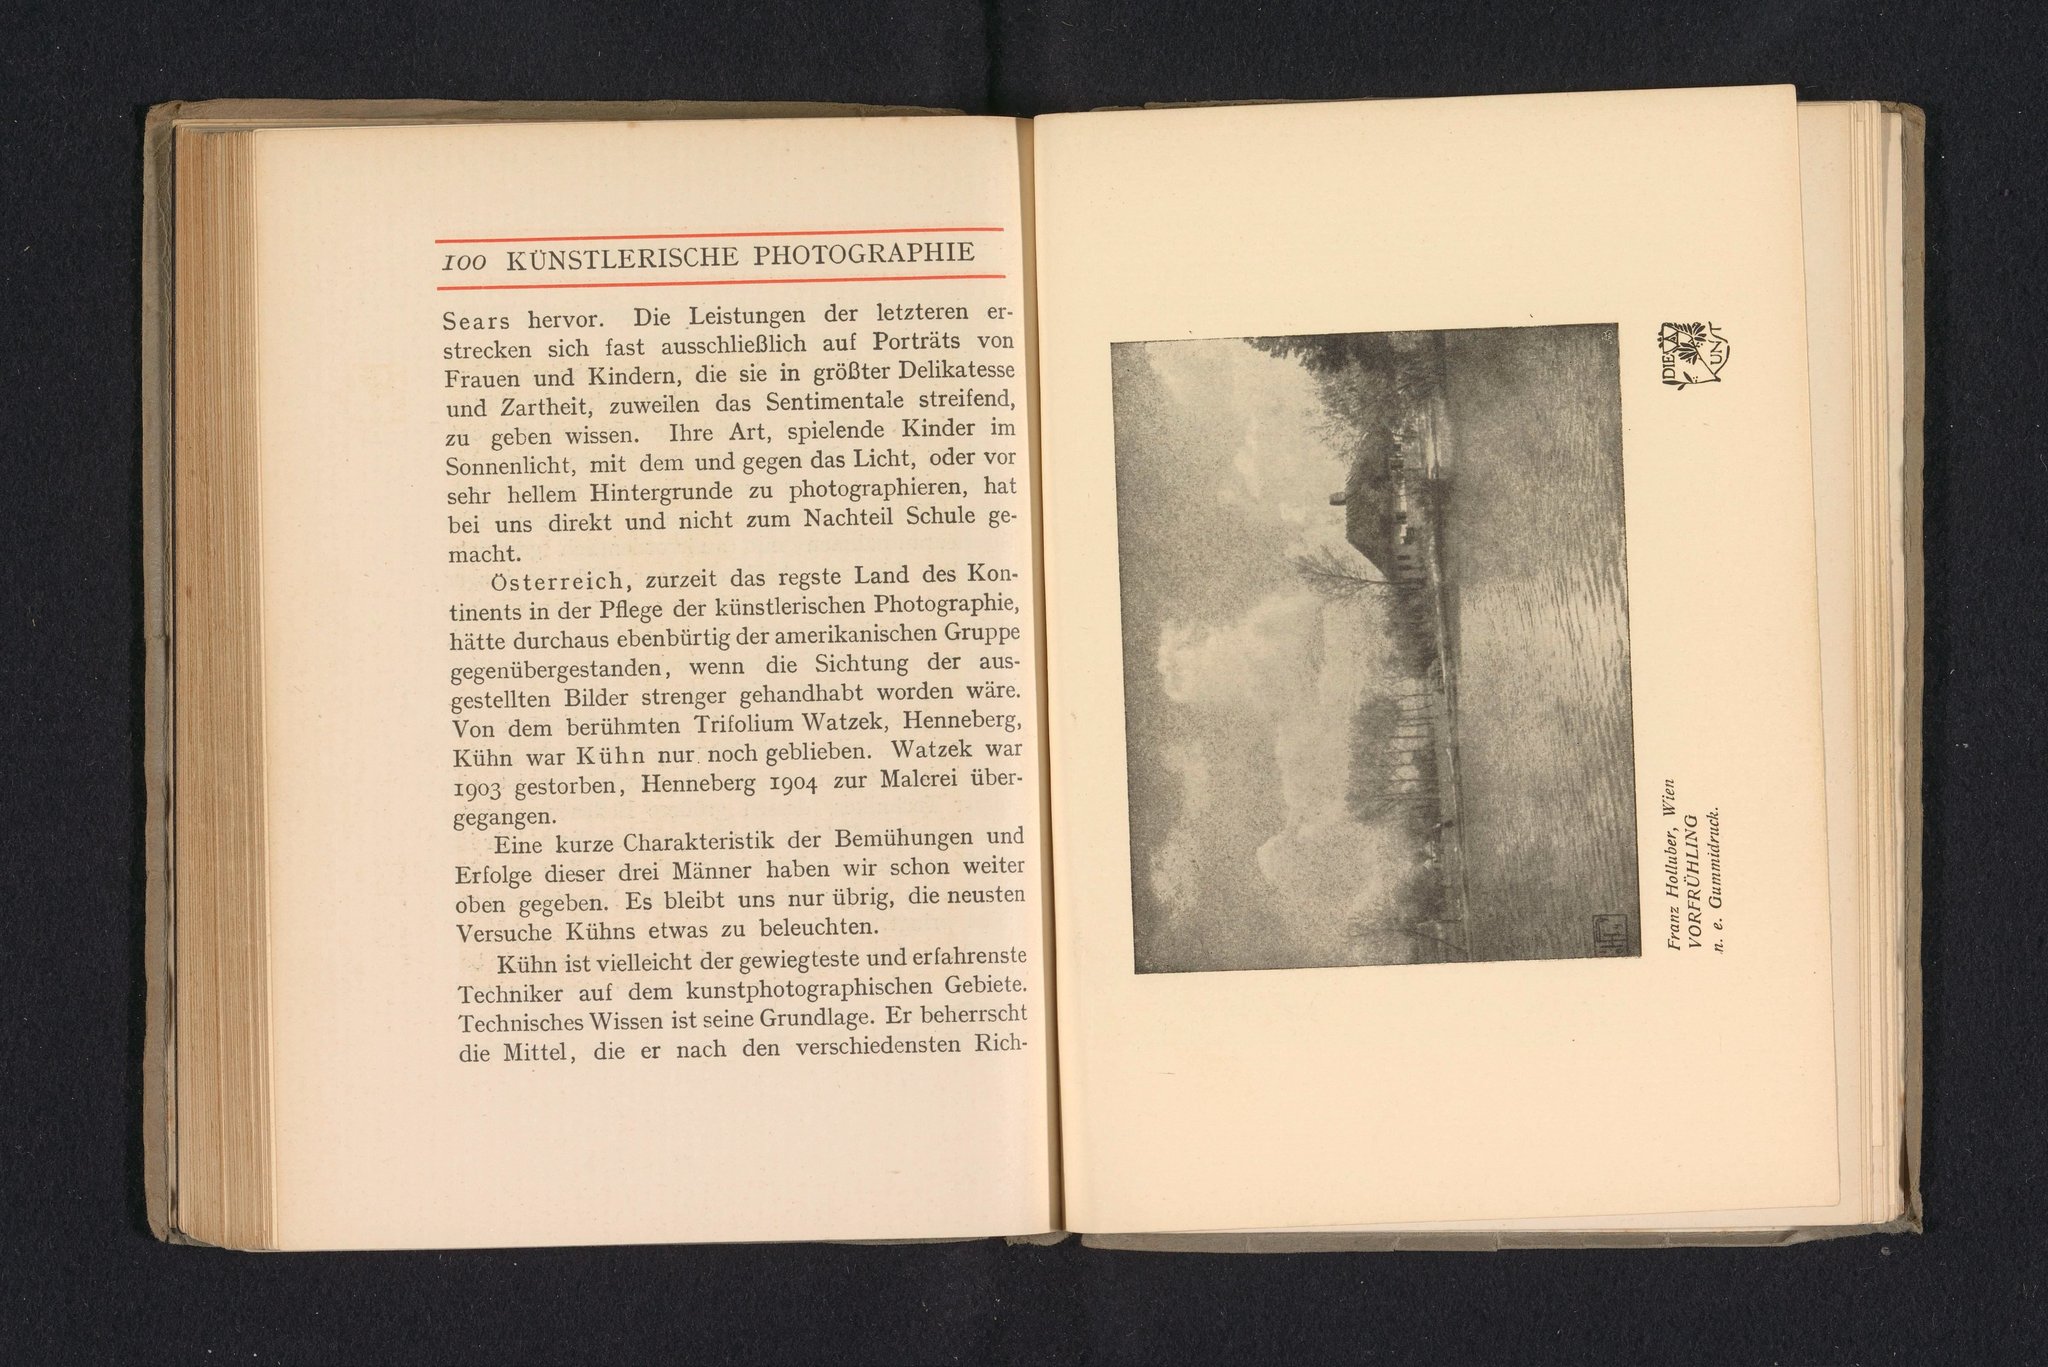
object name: reproduction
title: Fotoreproductie van een foto door Franz Holluber, voorstellend een landschap met water en een huis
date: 1880-1907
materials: paper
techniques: autotype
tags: landscapes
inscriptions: inscription: ‘n.e. Gummidruck.’